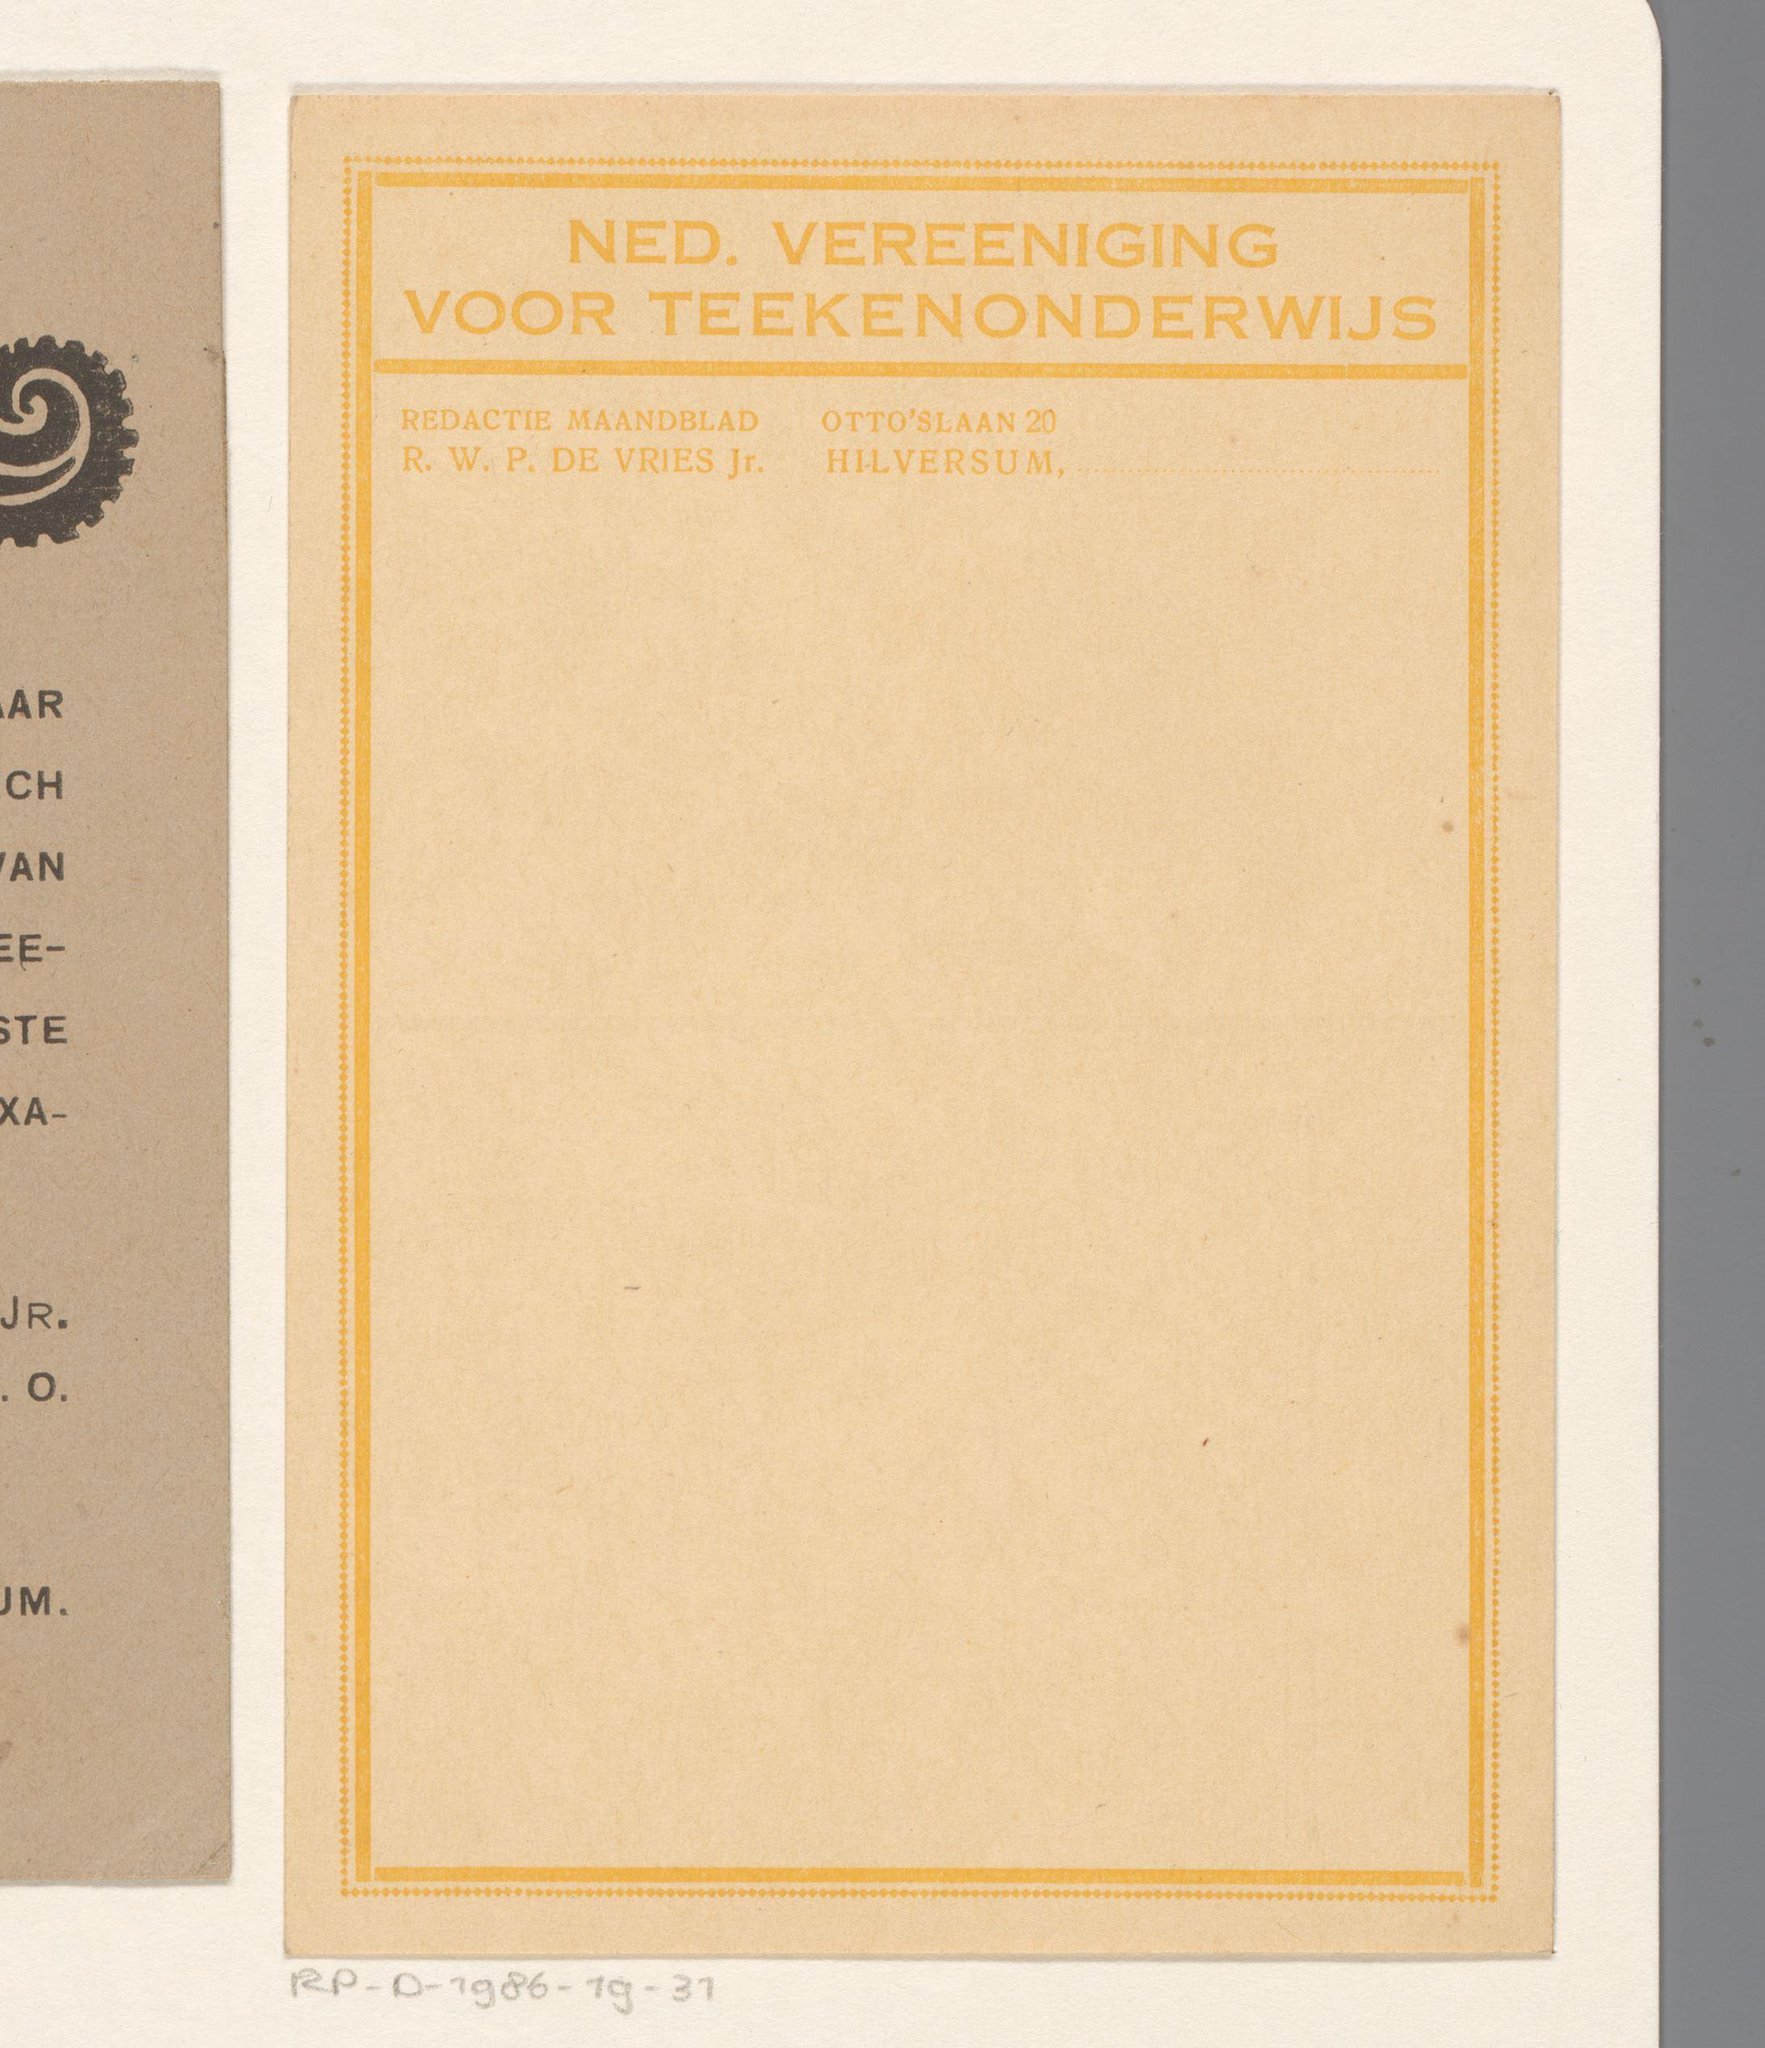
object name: postcard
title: Blanco briefkaart van de Nederlandse Vereeniging voor Teekenonderwijs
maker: Anonymous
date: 1880-1986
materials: paper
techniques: relief print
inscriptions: collector's mark: ‘R:MVS.’